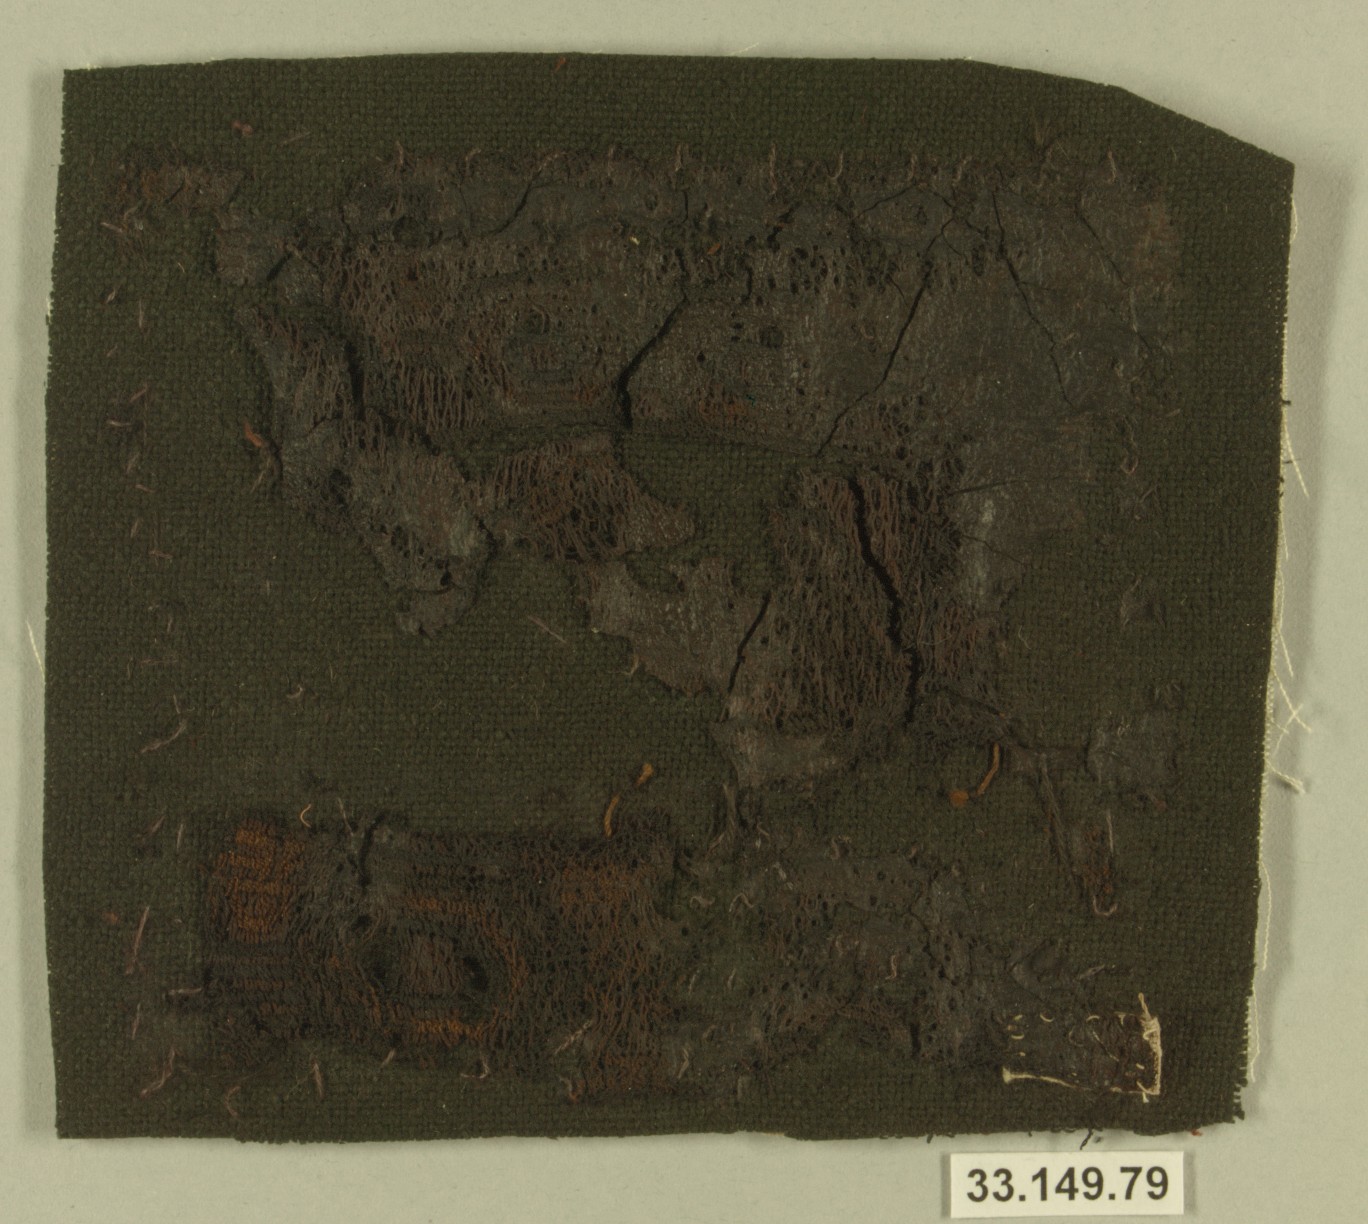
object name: textile fragment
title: Embroidered Fragment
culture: paracas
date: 500-101 BCE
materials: animal fiber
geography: peru